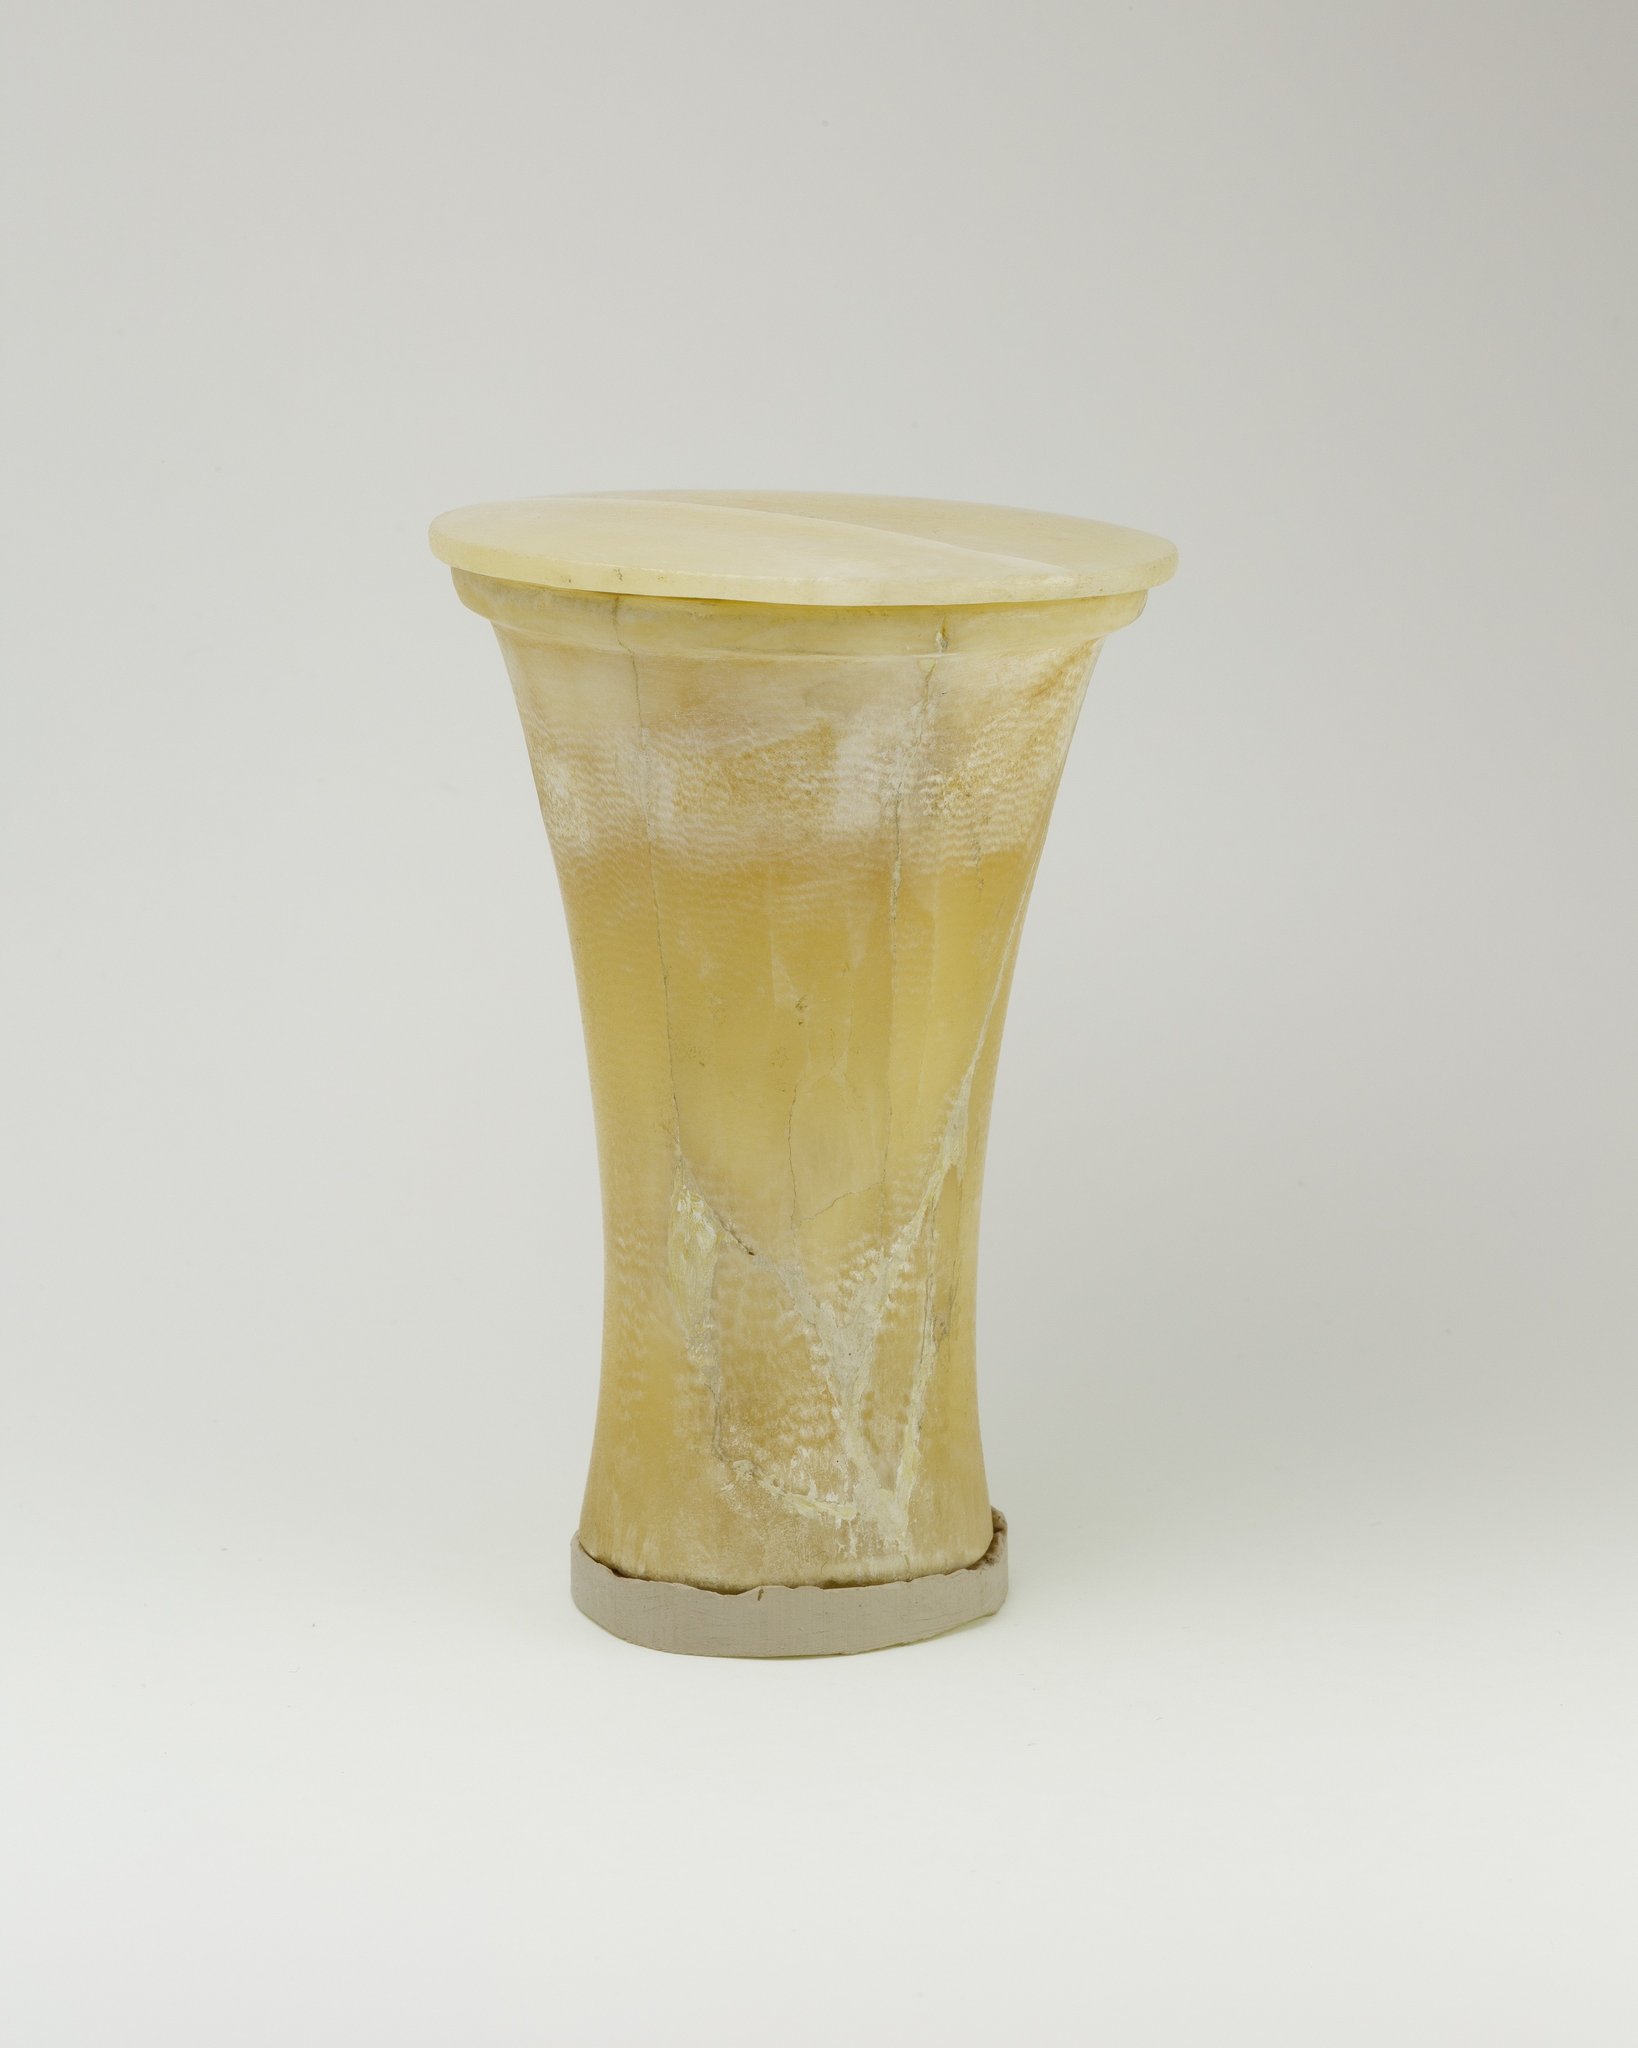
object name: ointment jar, sithathoryunet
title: Ointment jar of Sithathoryunet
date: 1887-1813 BCE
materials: stone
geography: egypt